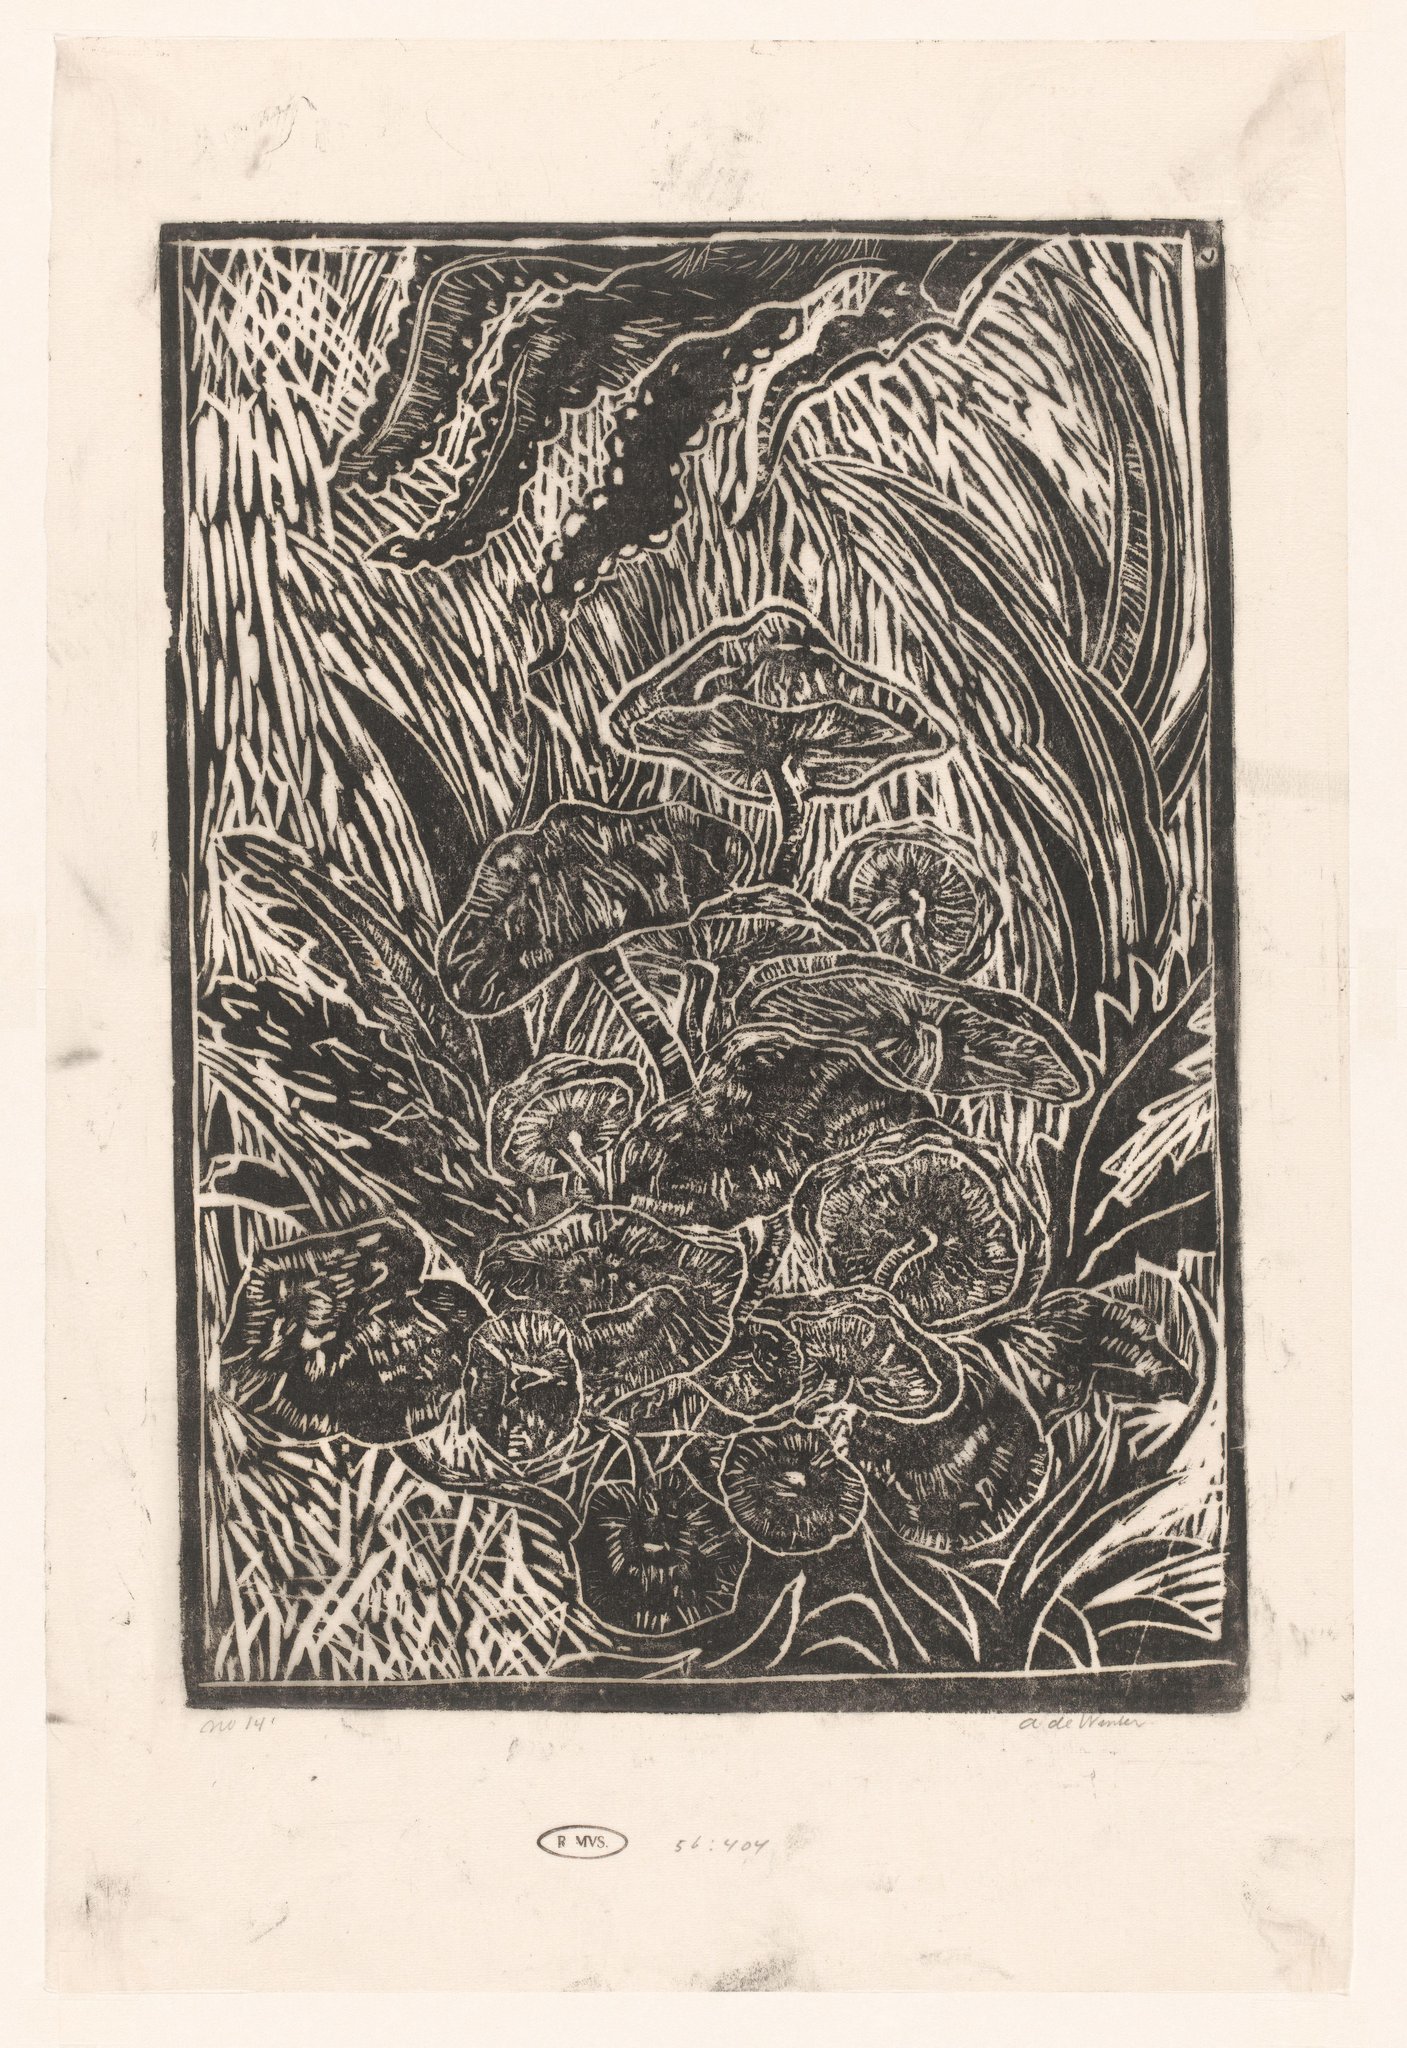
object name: print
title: Paddenstoelen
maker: janus de winter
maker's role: print maker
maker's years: 1882-1951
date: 1892-1951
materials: paper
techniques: woodcut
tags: mushrooms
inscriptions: collector's mark: Lugt 2228, inscription: ‘No 14’